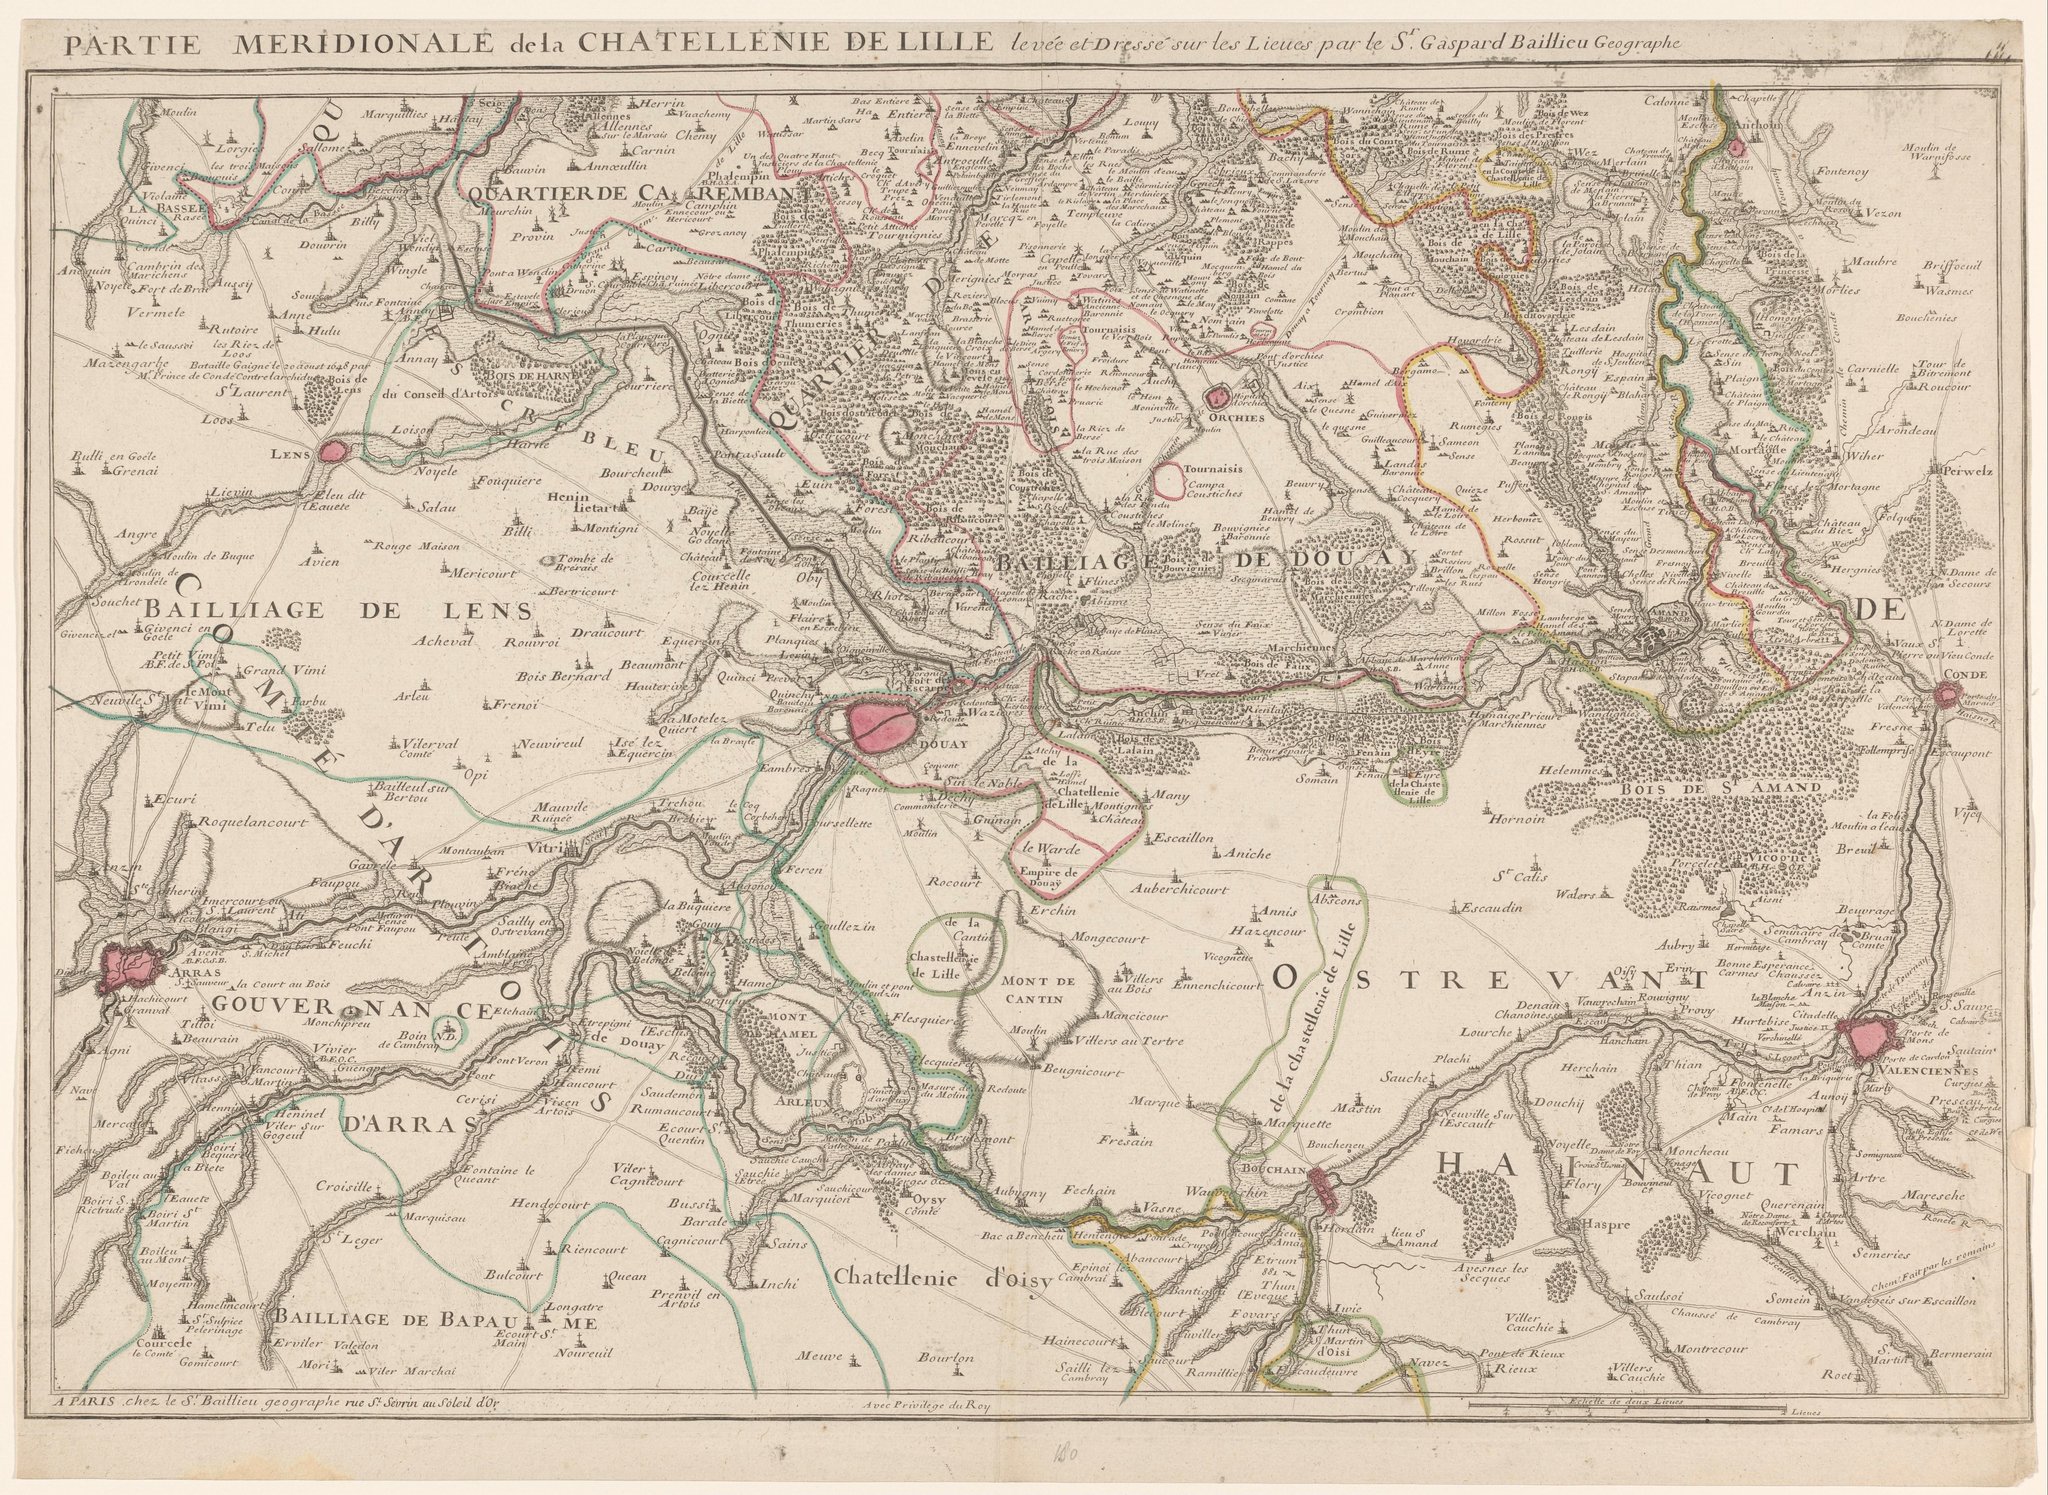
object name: print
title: Kaart van de kasselrij Rijsel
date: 1690-1744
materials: paper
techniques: engraving, etching, hand coloring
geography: paris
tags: maps of cities, lille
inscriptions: collector's mark: Lugt 2228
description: Kaart van de kasselrij Rijsel (Lille). Boven de kaart de titel. Rechtsonder een schaalstok: Echelle de deux Lieues.